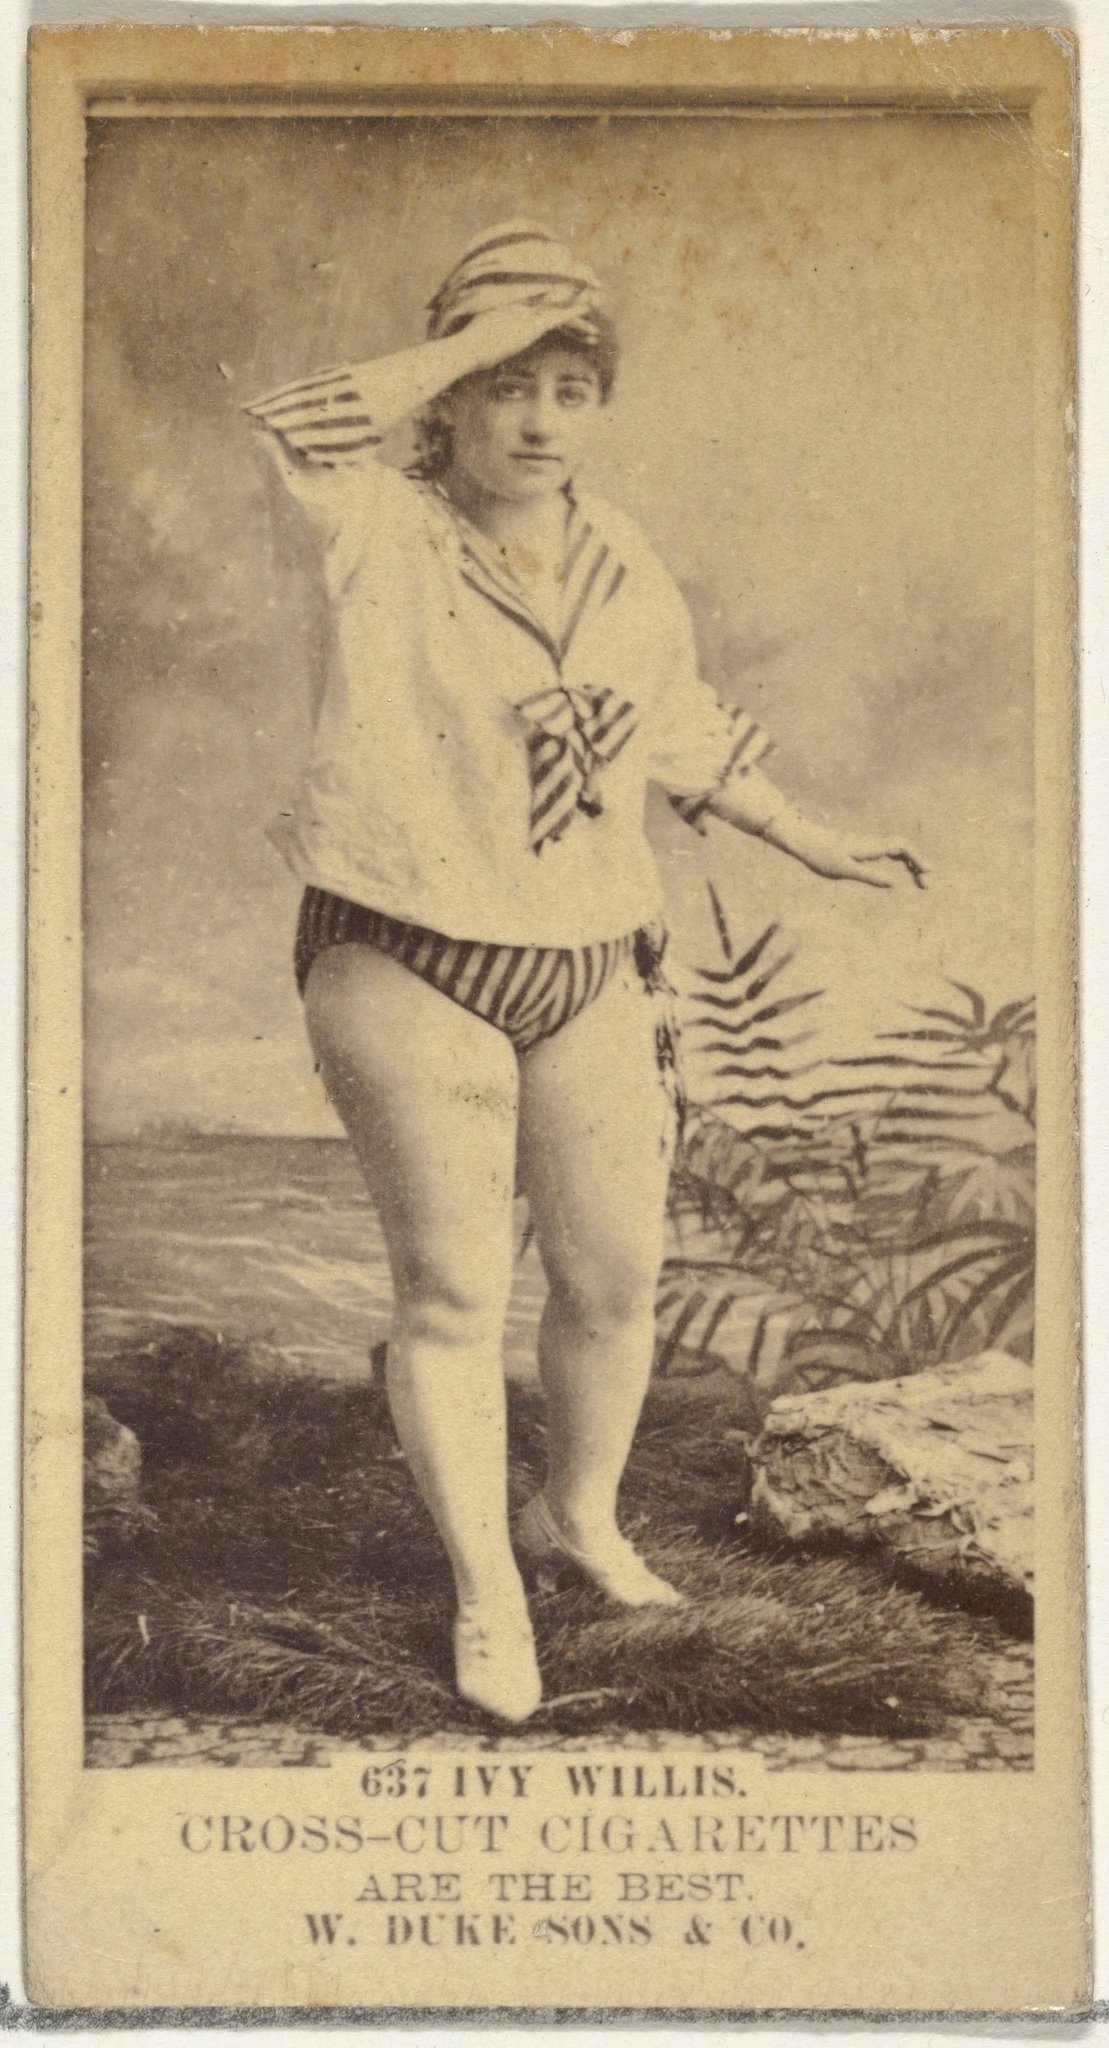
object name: photograph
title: Card Number 637, Ivy Willis, from the Actors and Actresses series (N145-3) issued by Duke Sons & Co. to promote Cross Cut Cigarettes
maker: w. duke, sons & co.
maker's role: publisher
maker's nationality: american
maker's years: 1870-1920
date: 1880-1889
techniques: albumen silver print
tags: portraits,women,actresses